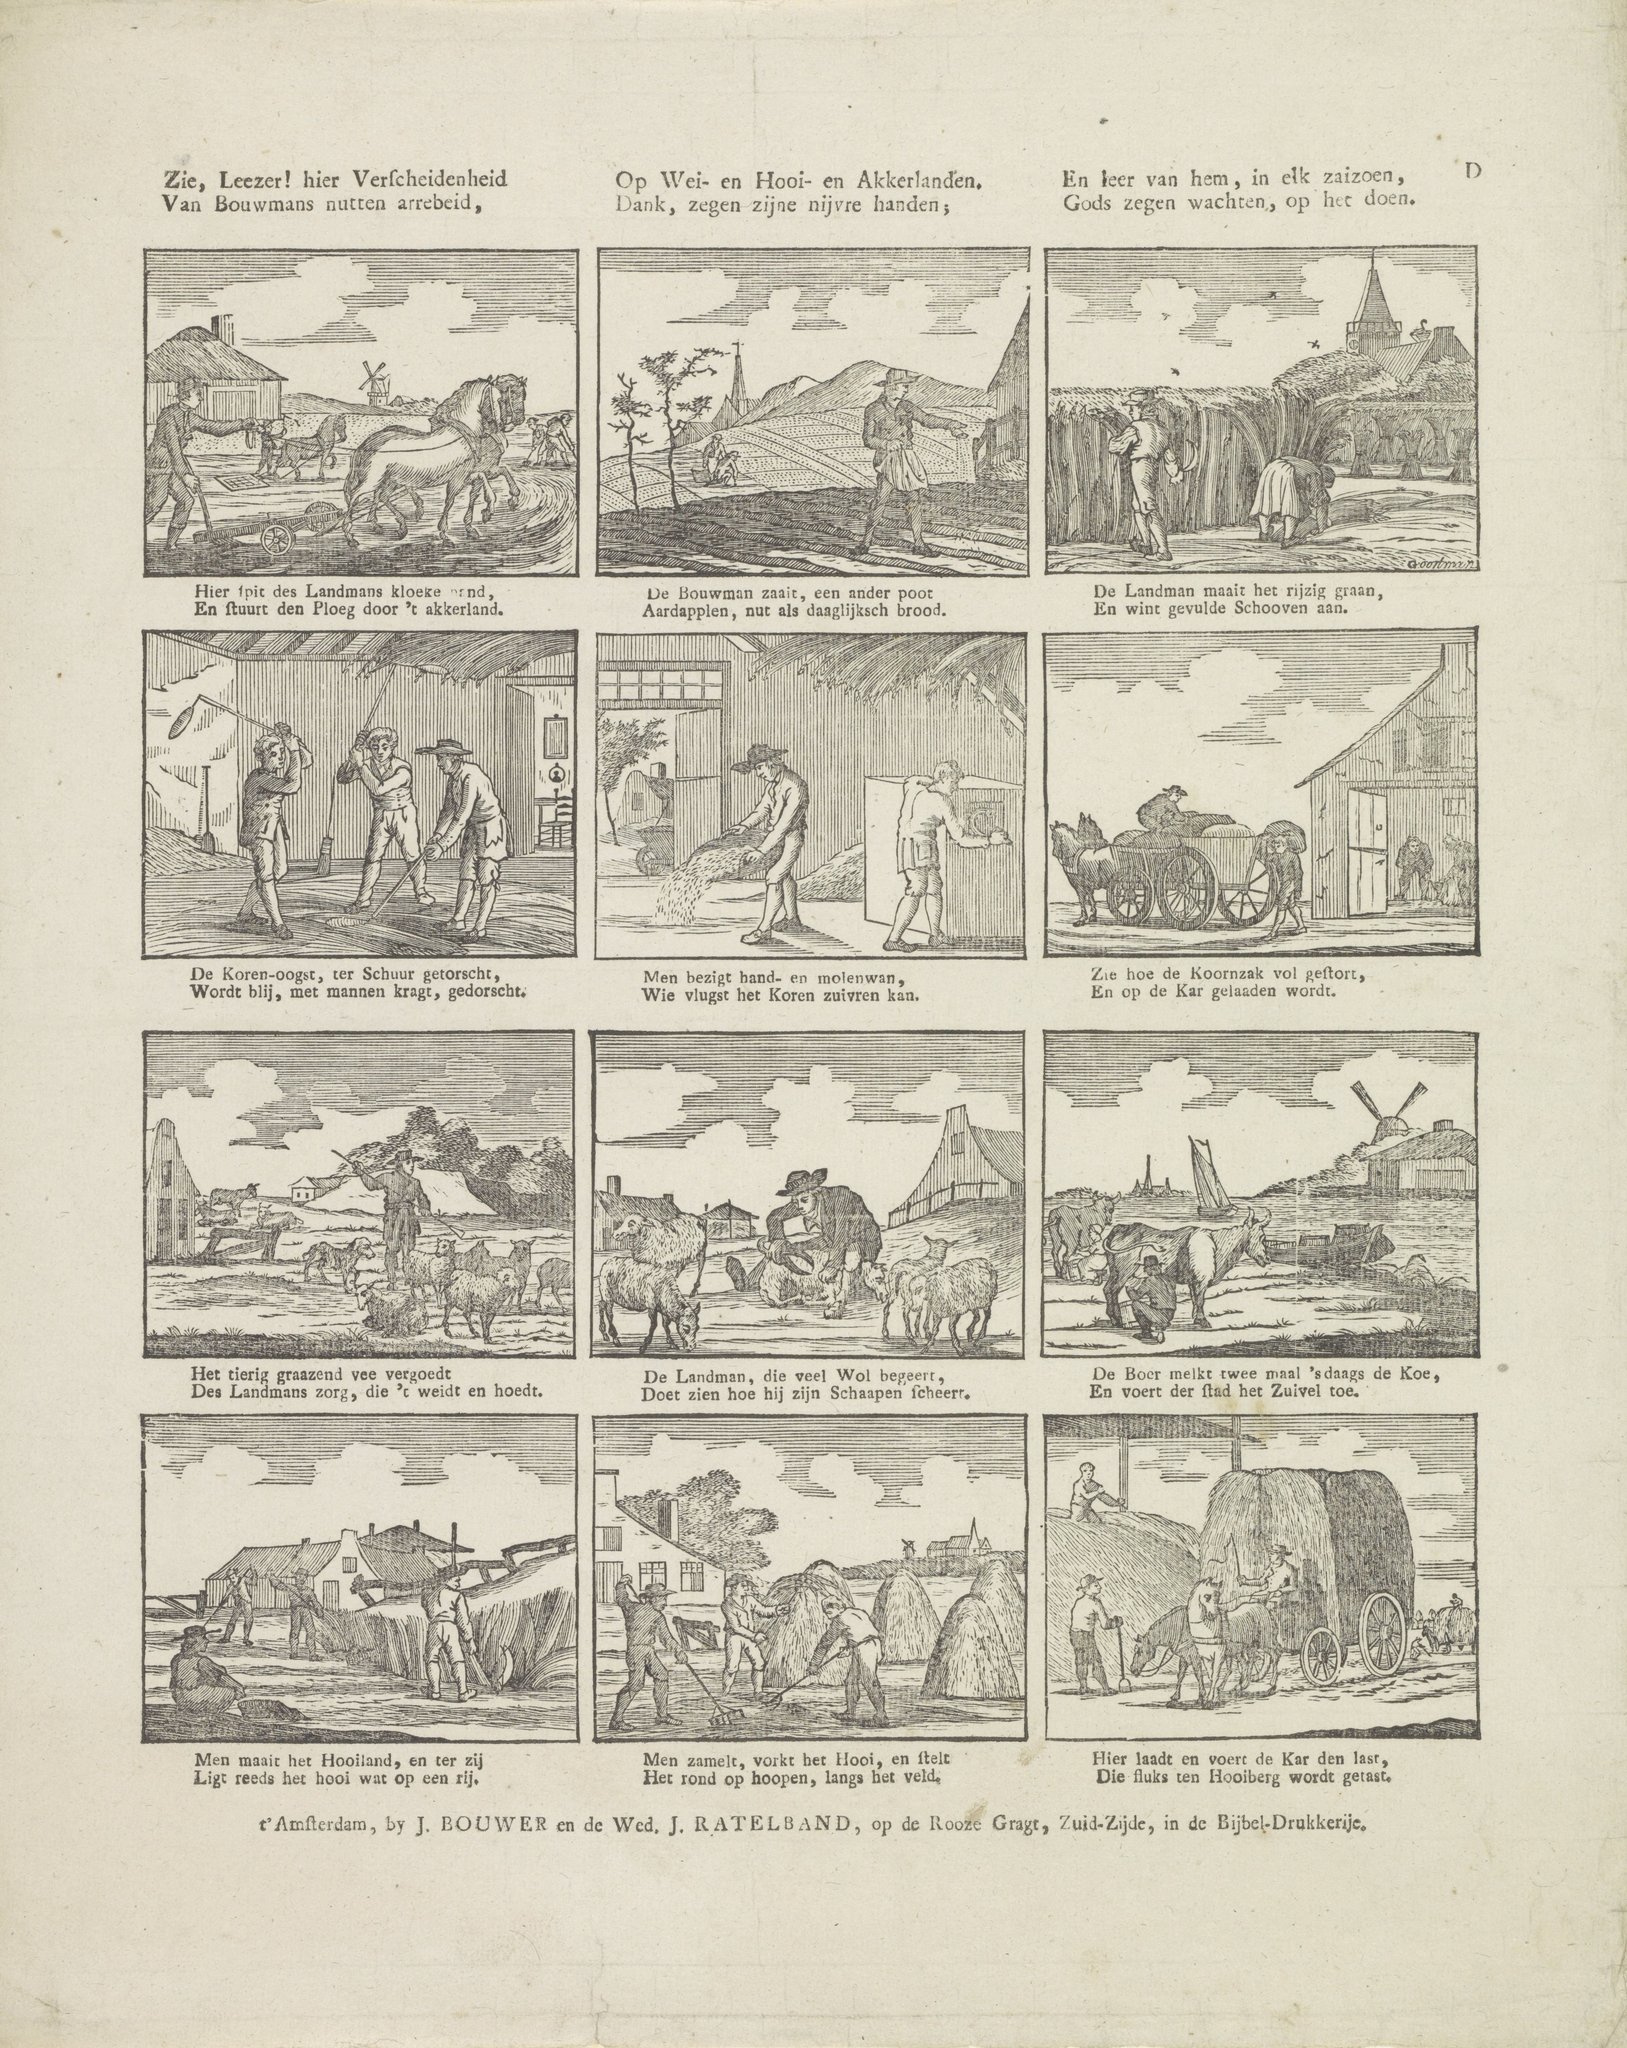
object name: popular print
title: Zie, leezer! hier verscheidenheid / Van bouwmans nutten arrebeid, [(...)]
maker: gerrit oortman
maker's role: print maker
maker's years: 1781-1822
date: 1794-1804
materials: paper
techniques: letterpress printing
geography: amsterdam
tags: farmers, agriculture, cattle-breeding, horticulture, flowerculture, etc.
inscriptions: collector's mark: Lugt 2760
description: Blad met 12 voorstellingen van het werk van de boer in landbouw en veeteelt. Onder elke afbeelding een tweeregelig vers. Genummerd rechtsboven: D.